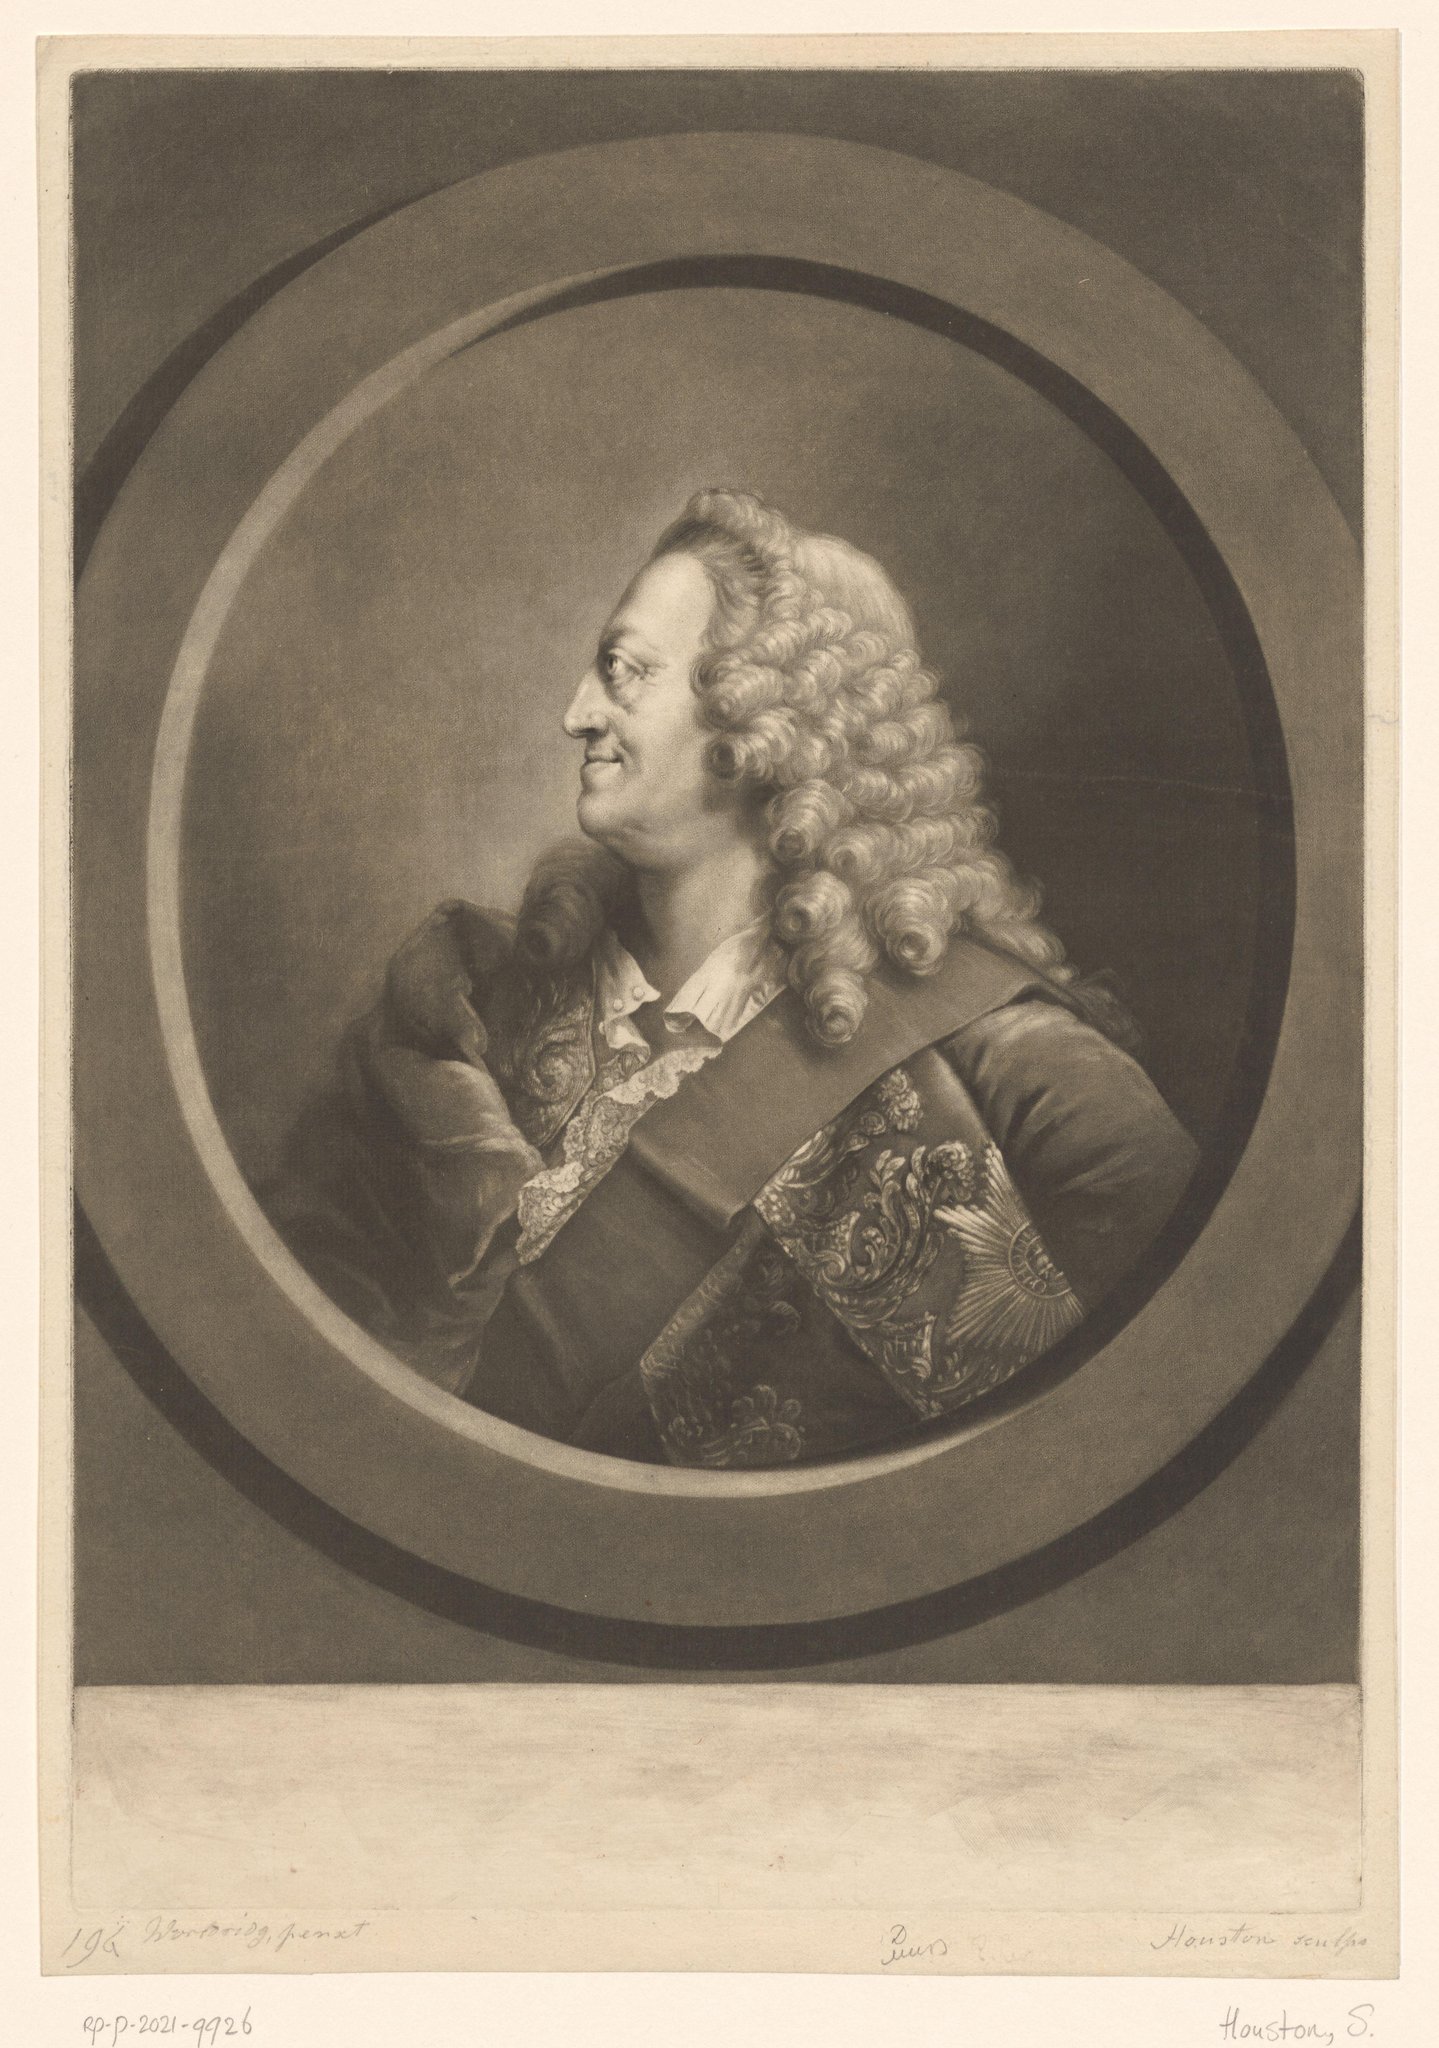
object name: print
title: Portret van George II, koning van Groot-Brittannië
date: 1727-1760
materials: paper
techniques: mezzotint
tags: london, historical persons, king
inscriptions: collector's mark: Lugt 240